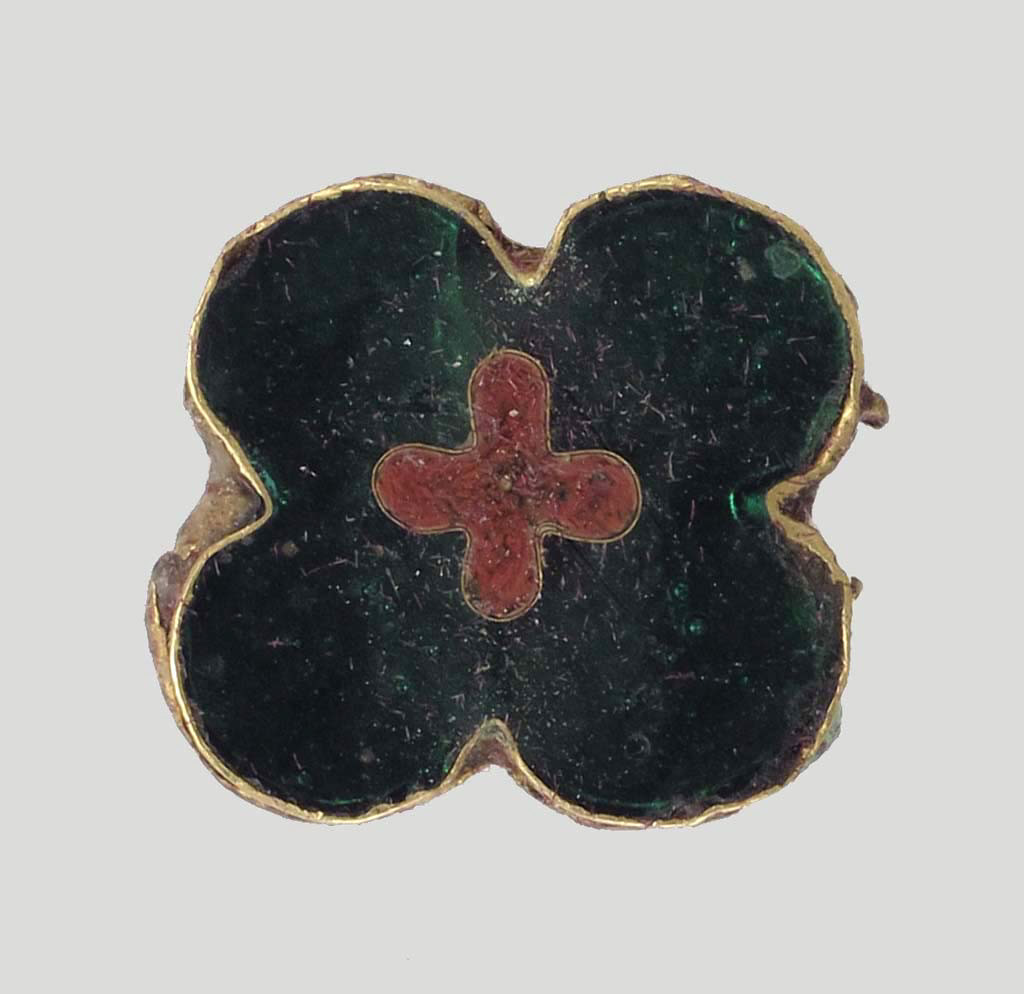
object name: enamel fragment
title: Fragment of a Flower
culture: french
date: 1001-1100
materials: enamel, gold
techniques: enamel